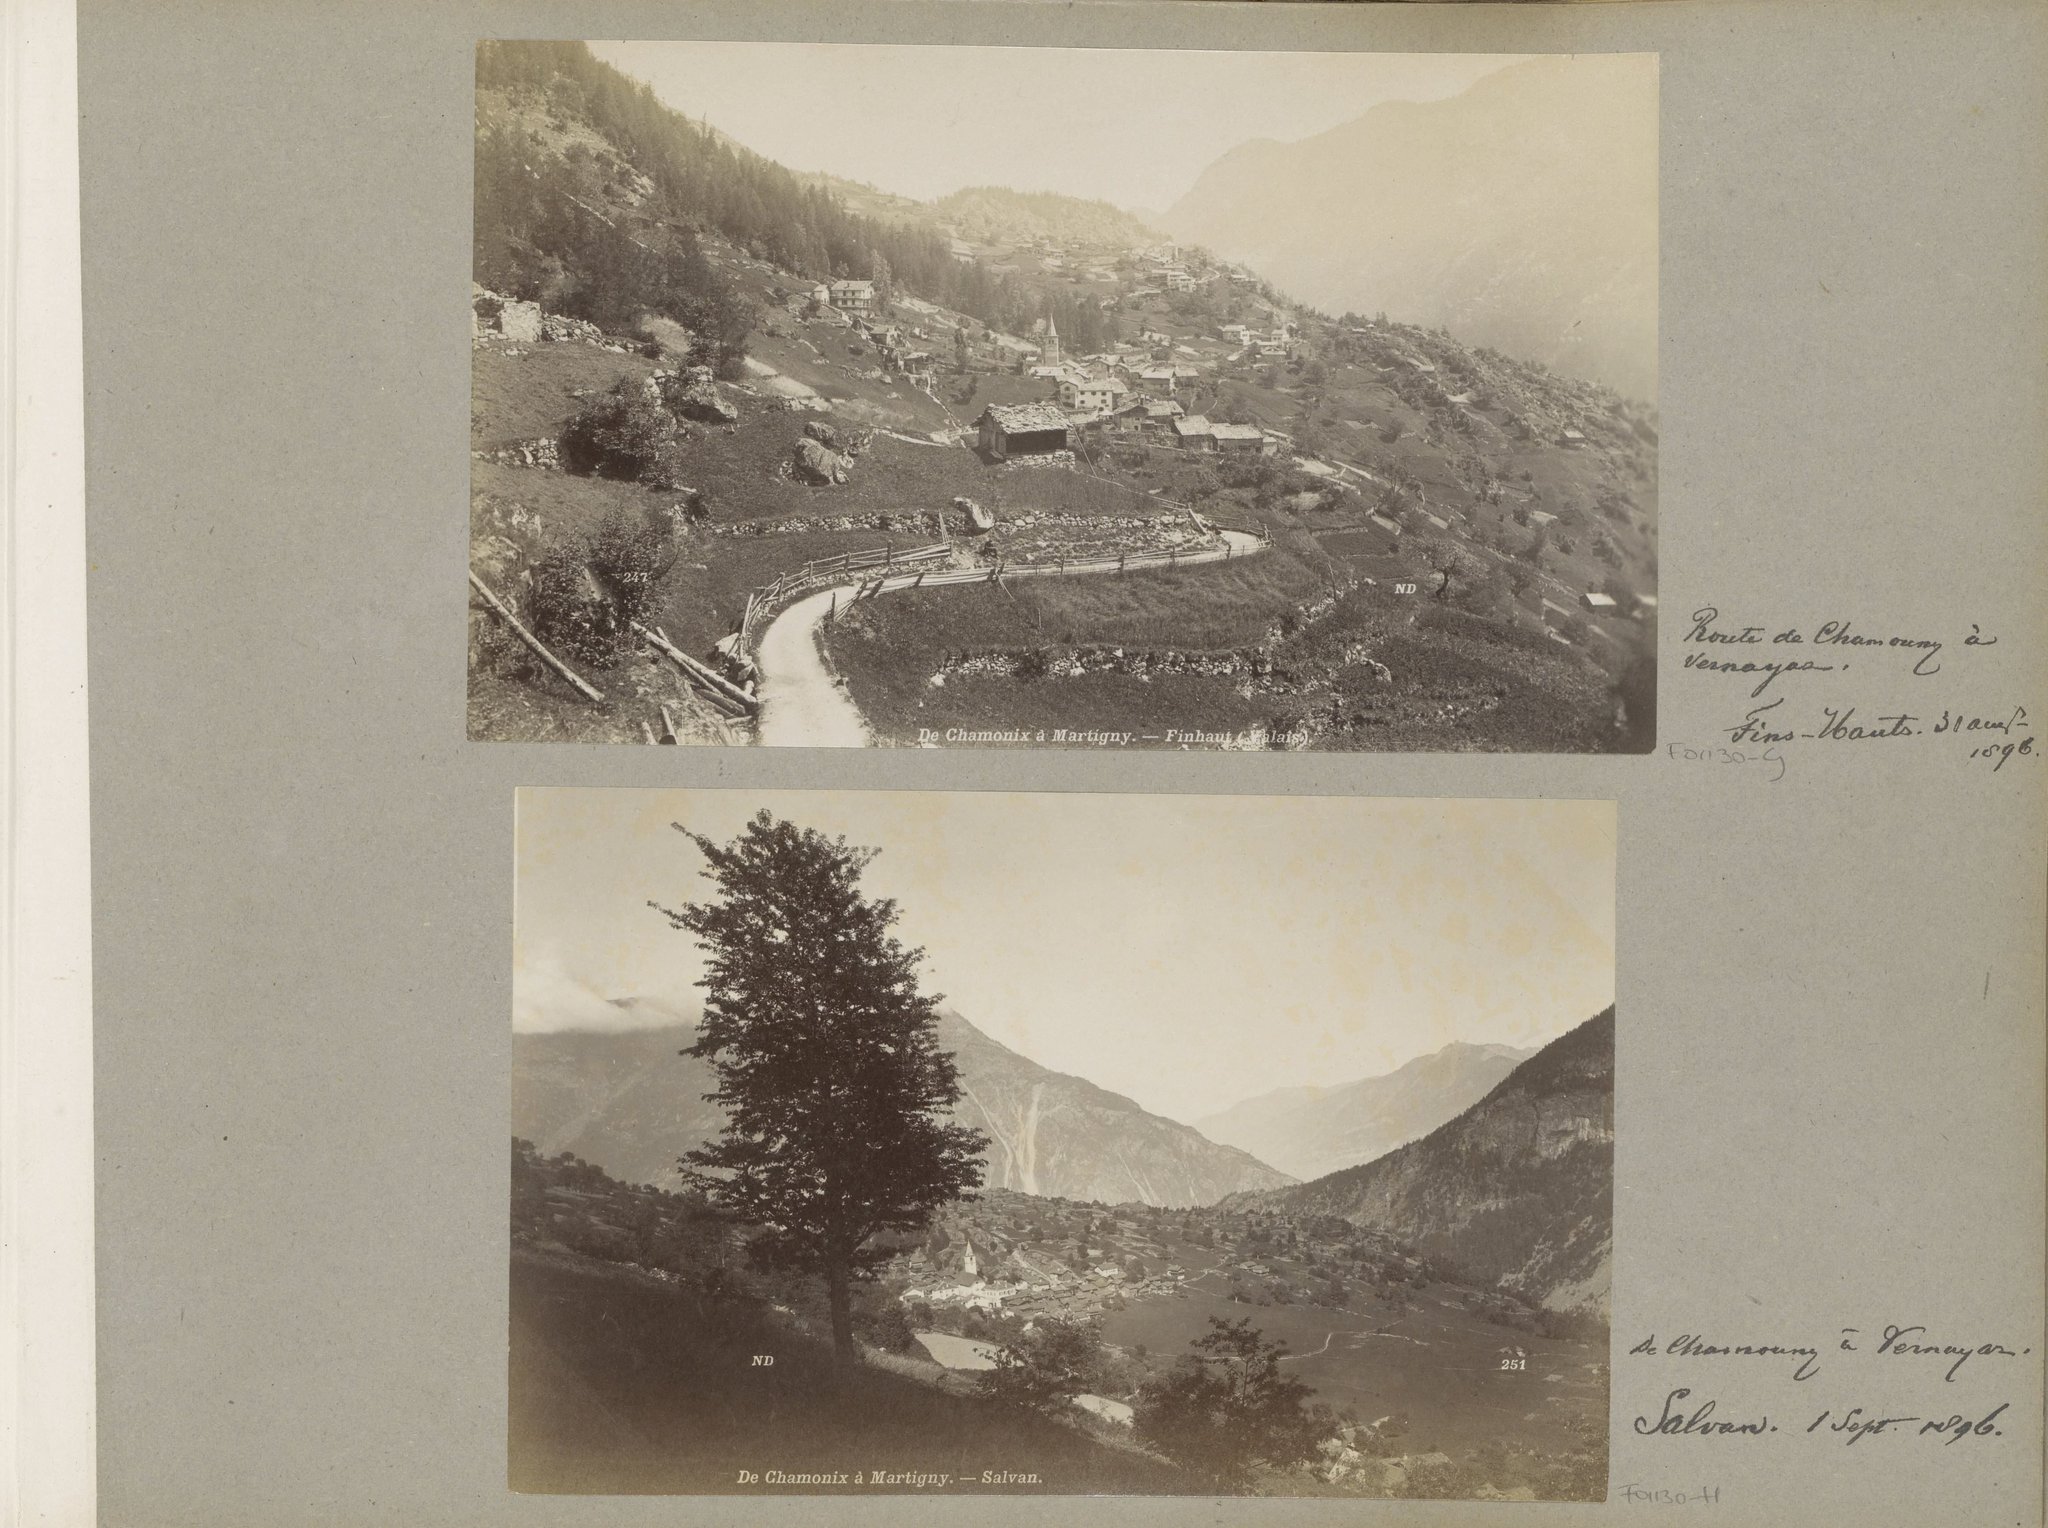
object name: photograph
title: Gezicht op Finhaut op de weg van Chamonix naar Martigny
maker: étienne neurdein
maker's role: publisher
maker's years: 1832-1918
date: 1880-1896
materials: paper, photographic support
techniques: albumen print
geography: finhaut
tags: prospect of village, silhouette of village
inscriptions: negative number: ‘247’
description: Onderdeel van Reisalbum met foto's van bezienswaardigheden in Frankrijk, Spanje, Italië, Duitsland, Zwitserland en Oostenrijk.